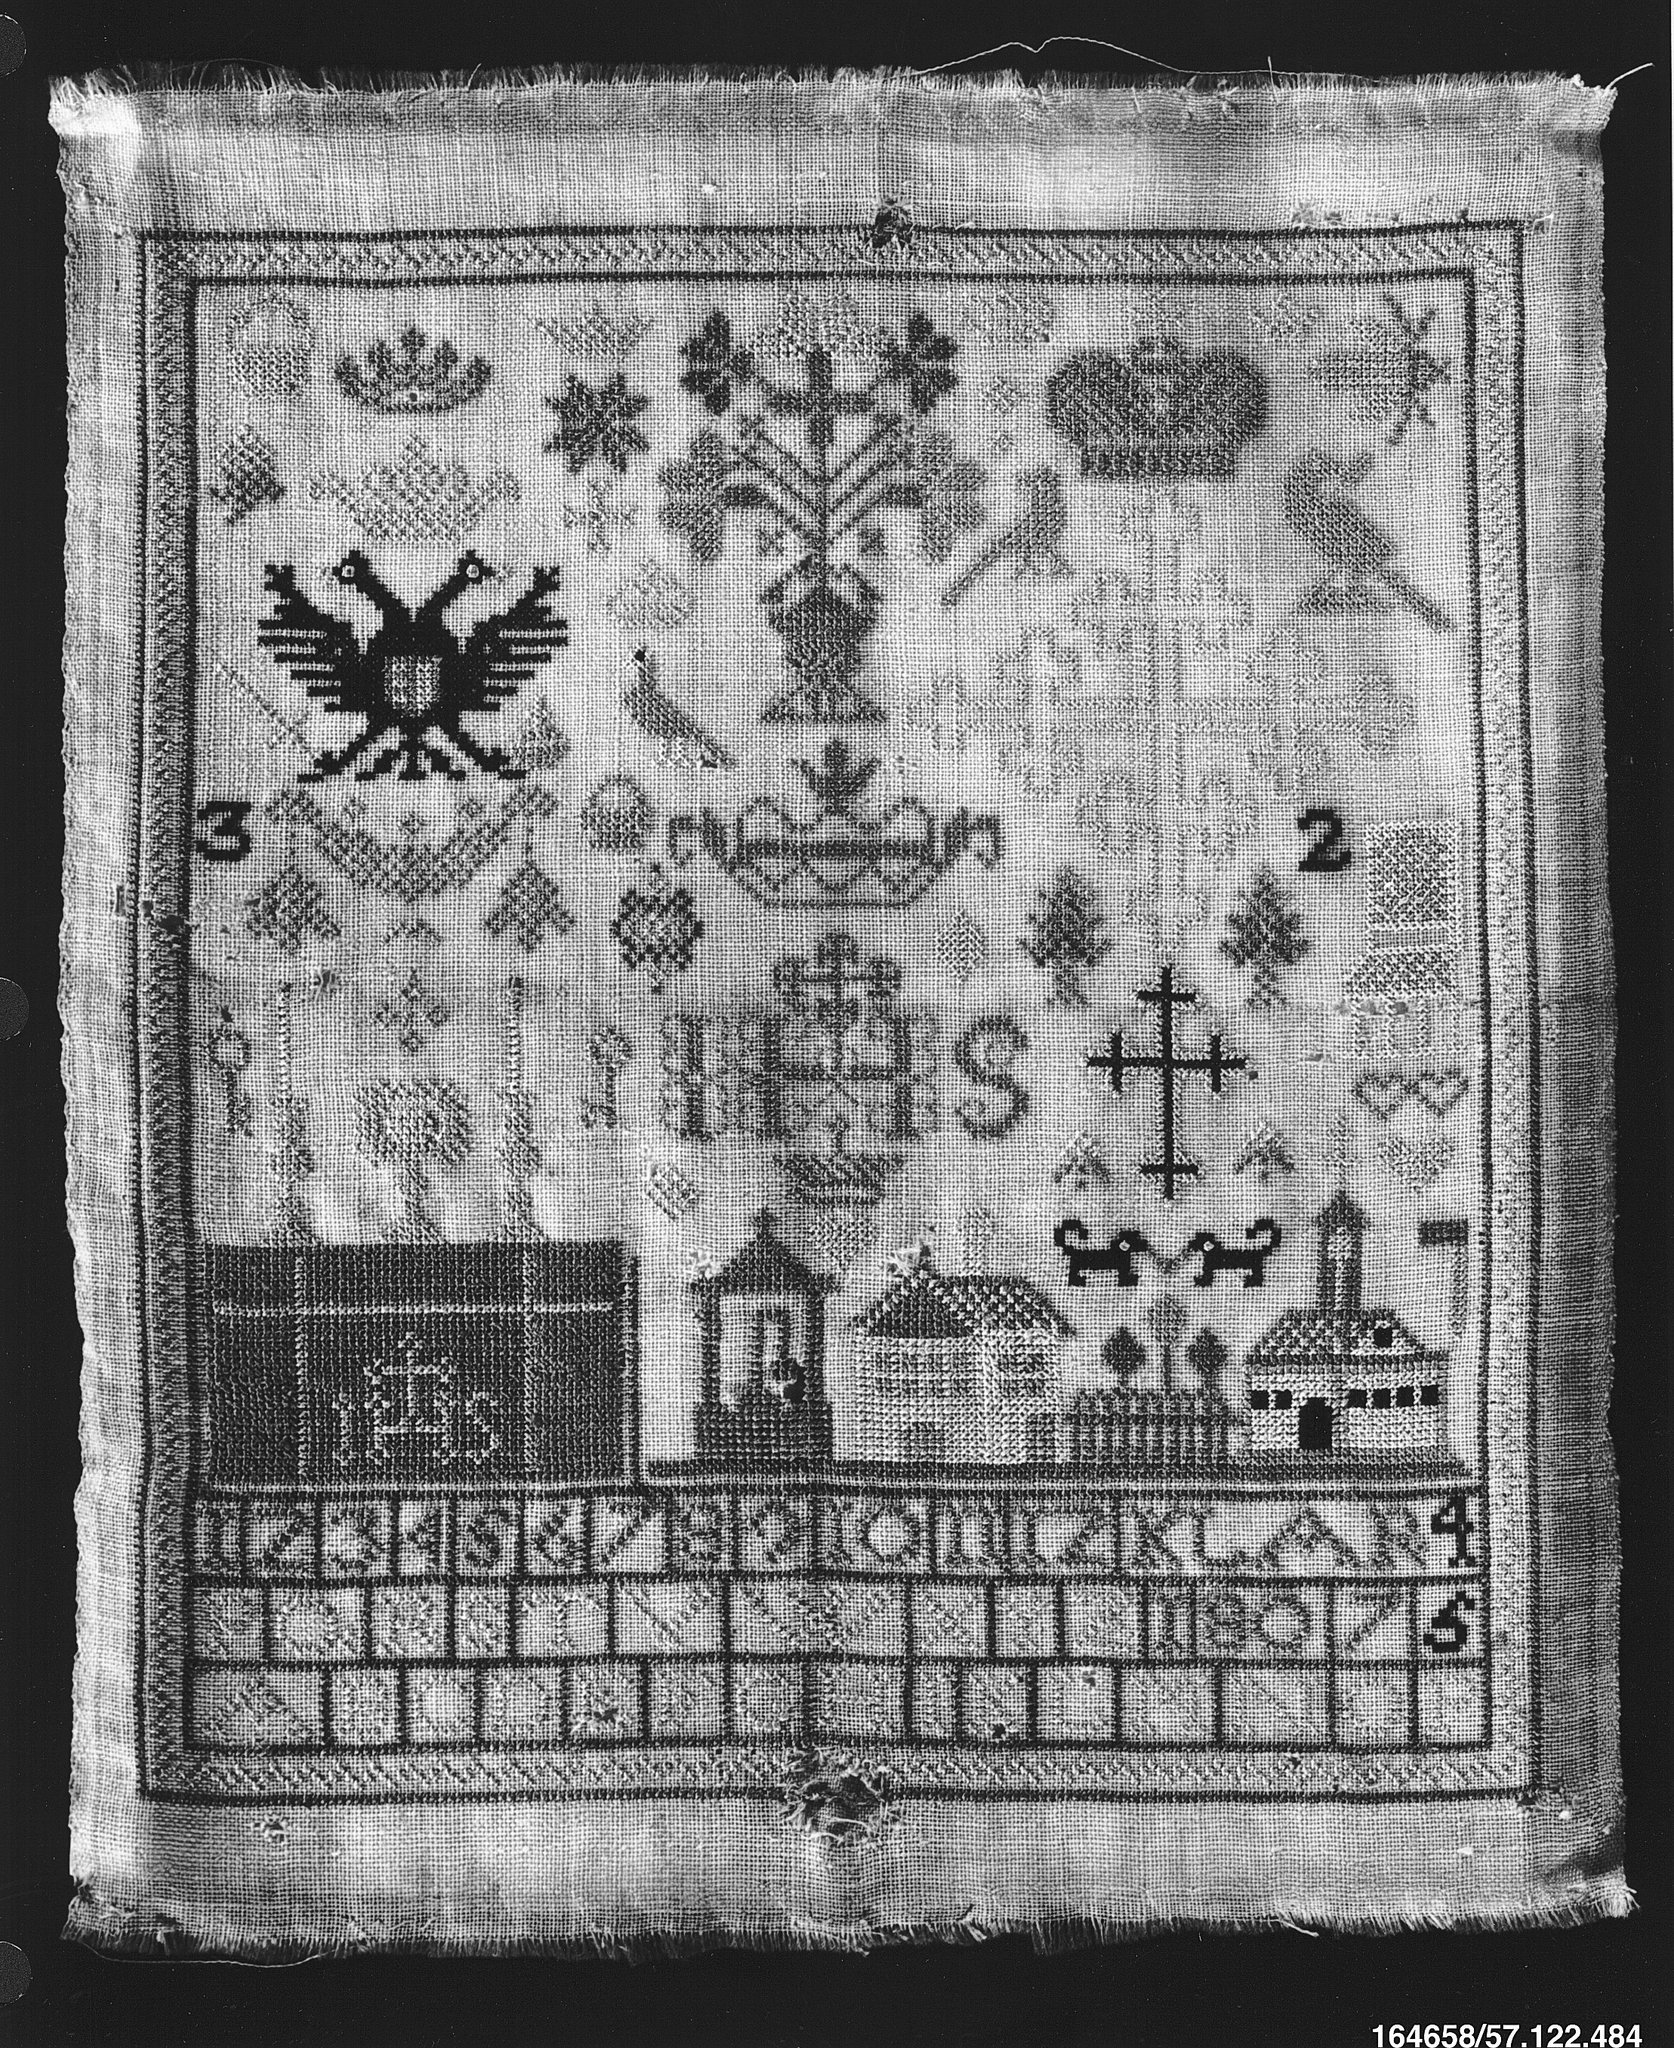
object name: sampler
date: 1807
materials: canvas, silk, wool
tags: birds,houses,dogs,insignia